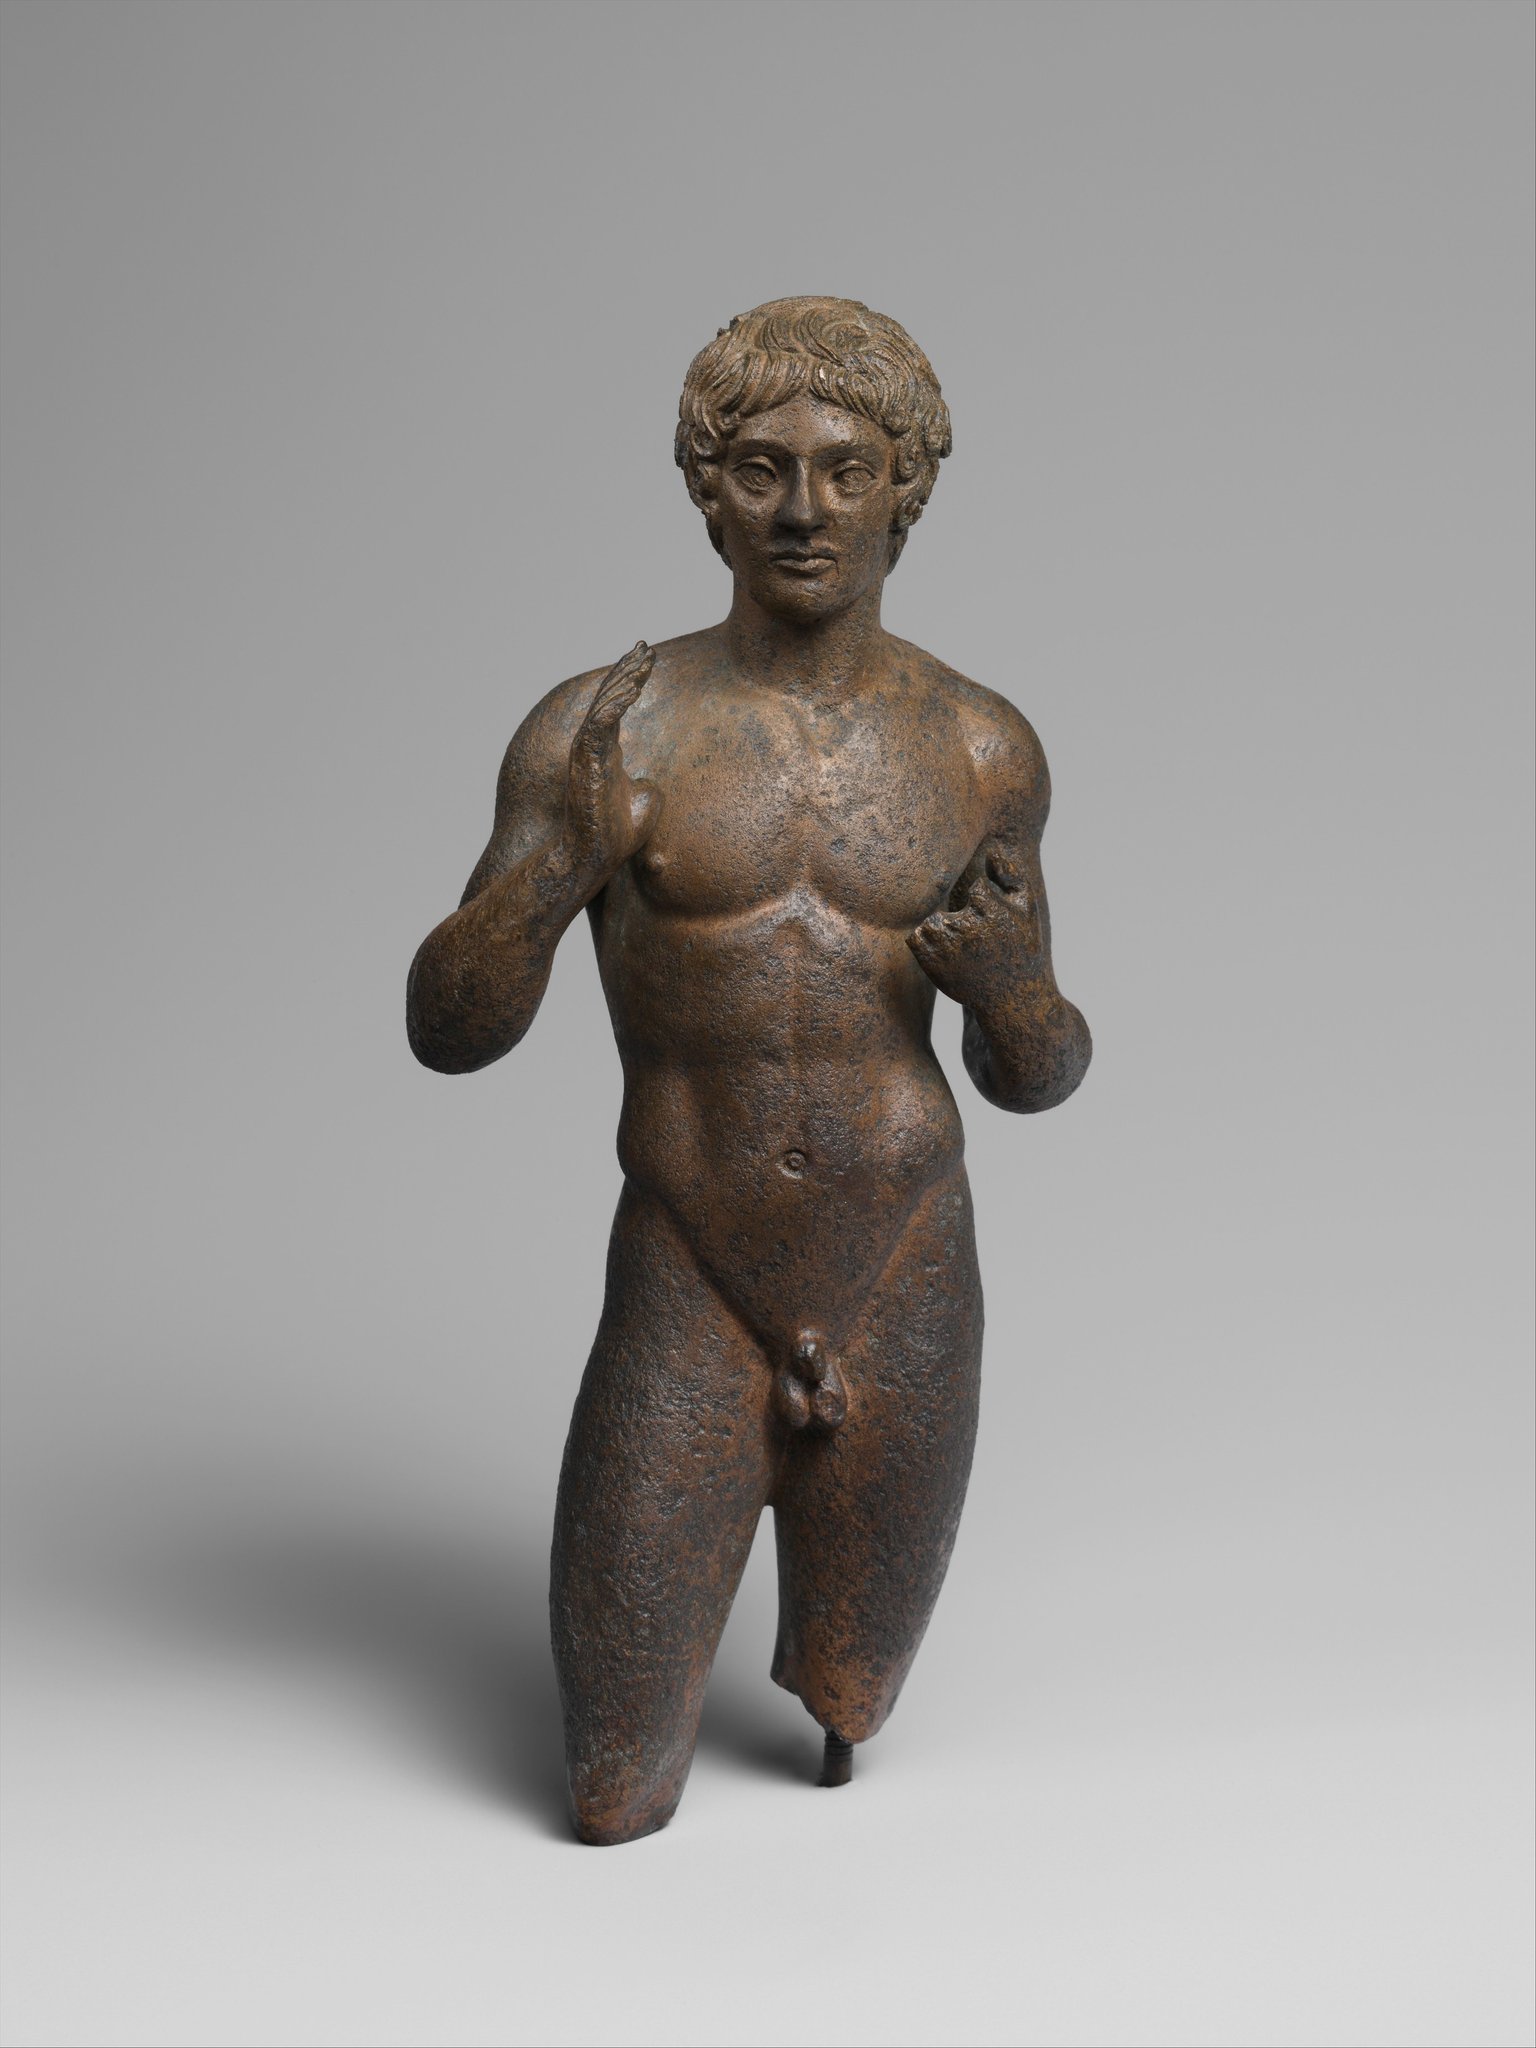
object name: statuette of a youth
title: Bronze statuette of a youth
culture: etruscan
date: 434-401 BCE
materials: bronze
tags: male nudes